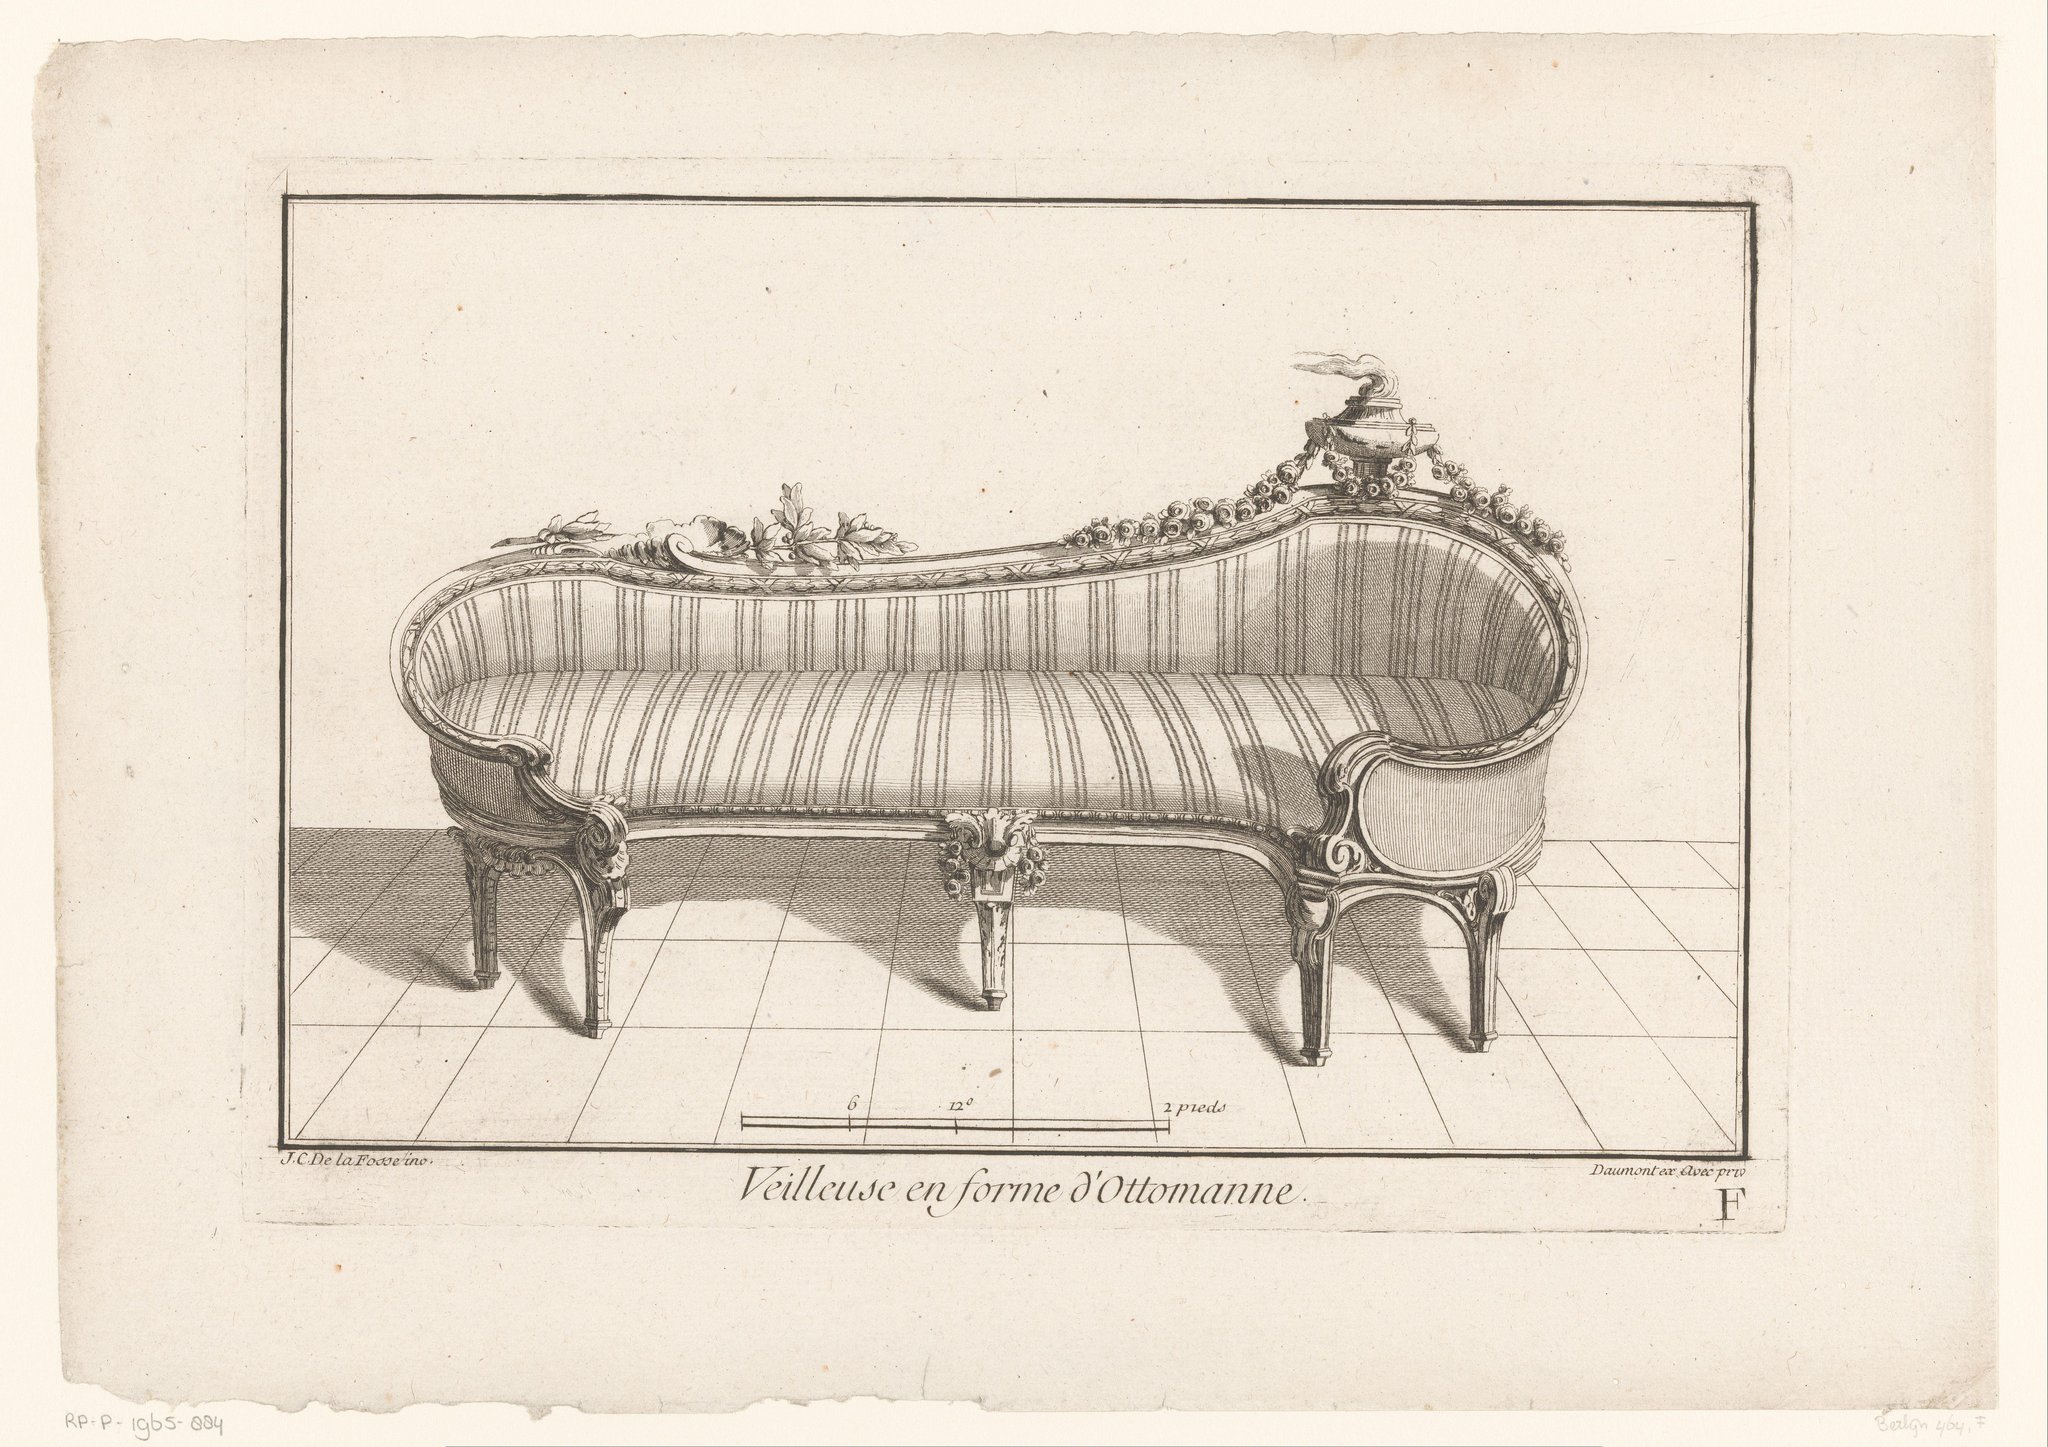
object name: ornament print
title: F Sofa's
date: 1745-1775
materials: paper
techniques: engraving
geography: paris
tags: incense-burner ~ scents, perfumes, couch, sofa, settee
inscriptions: collector's mark: Lugt 2228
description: Een sofa met gestreepte bekleding, bloemen, guirlandes en een rookvat.